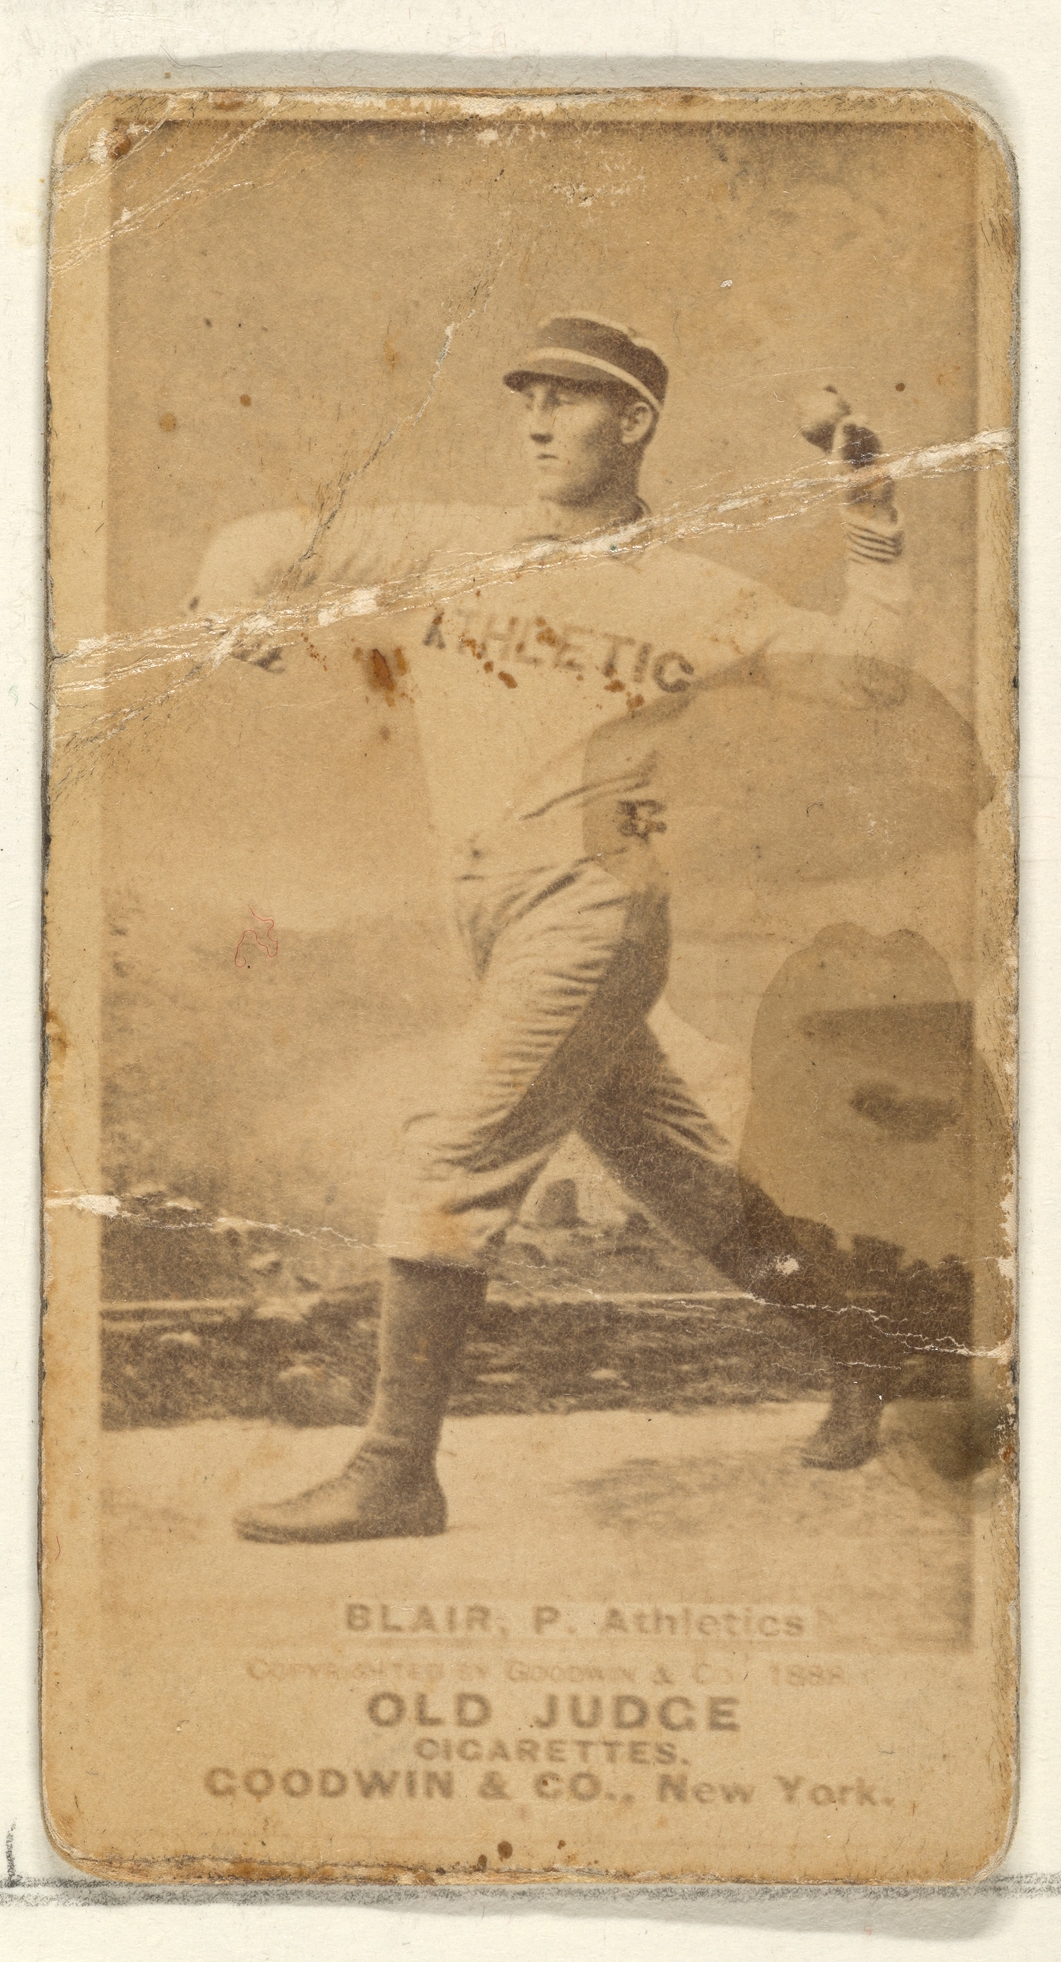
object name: baseball card, photograph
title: Blair, Pitcher, Philadelphia Athletics, from the Old Judge series (N172) for Old Judge Cigarettes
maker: goodwin & company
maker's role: publisher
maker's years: 1850-1950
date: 1888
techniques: albumen silver print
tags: men,portraits,baseball,athletes